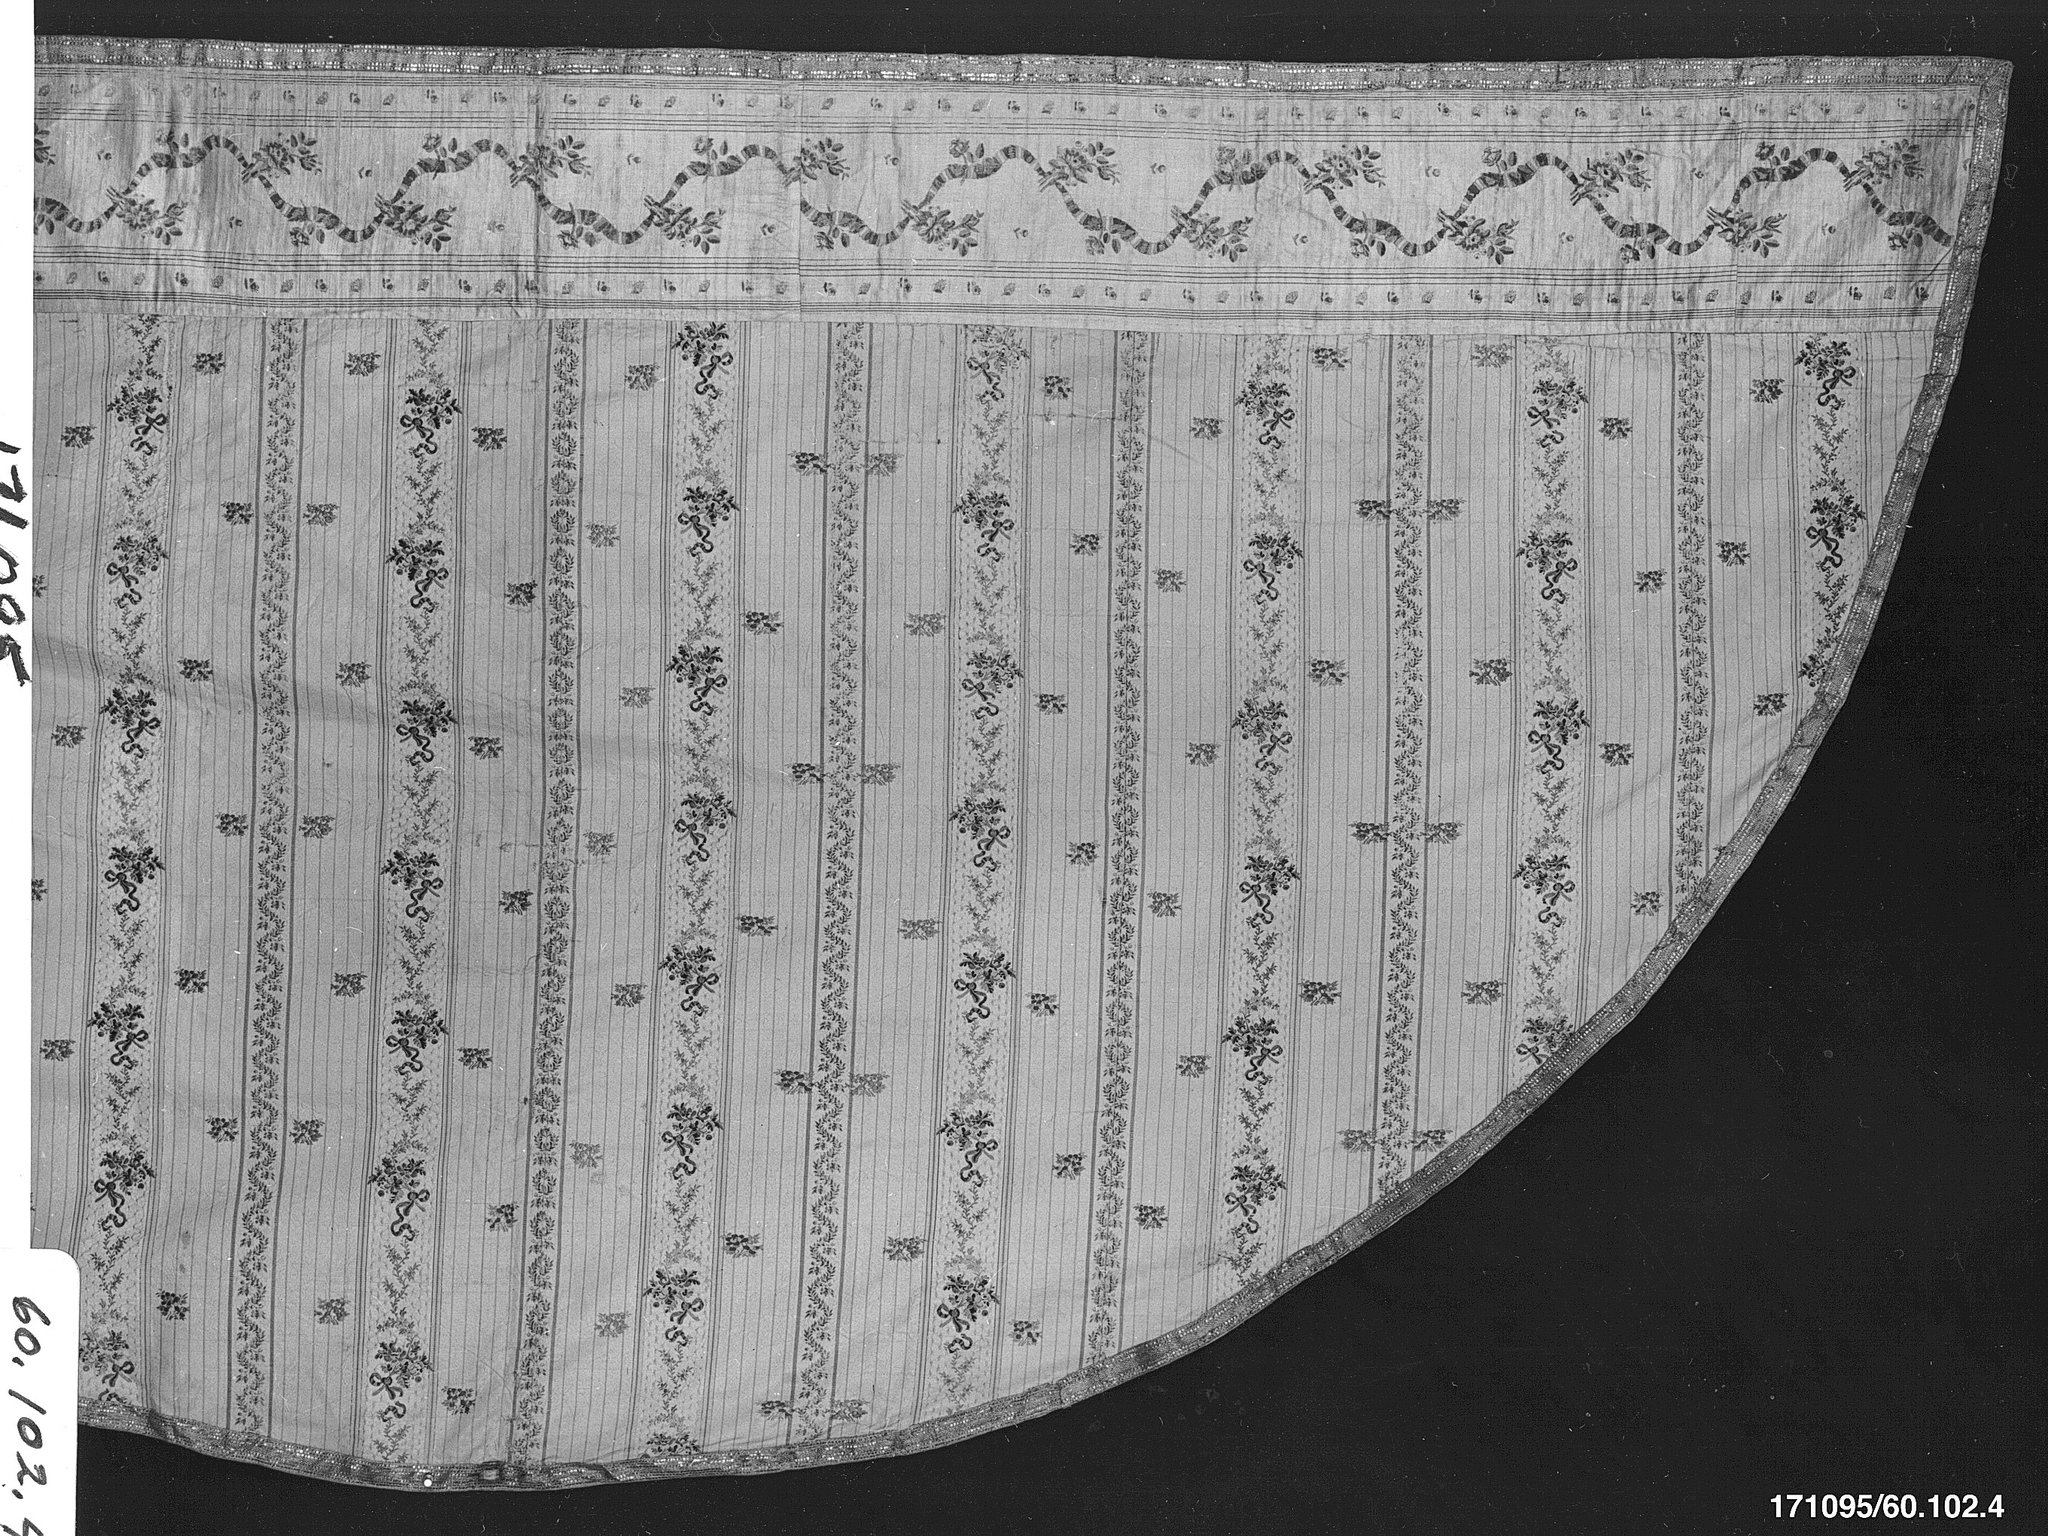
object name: cope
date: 1701-1800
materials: silk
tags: flowers